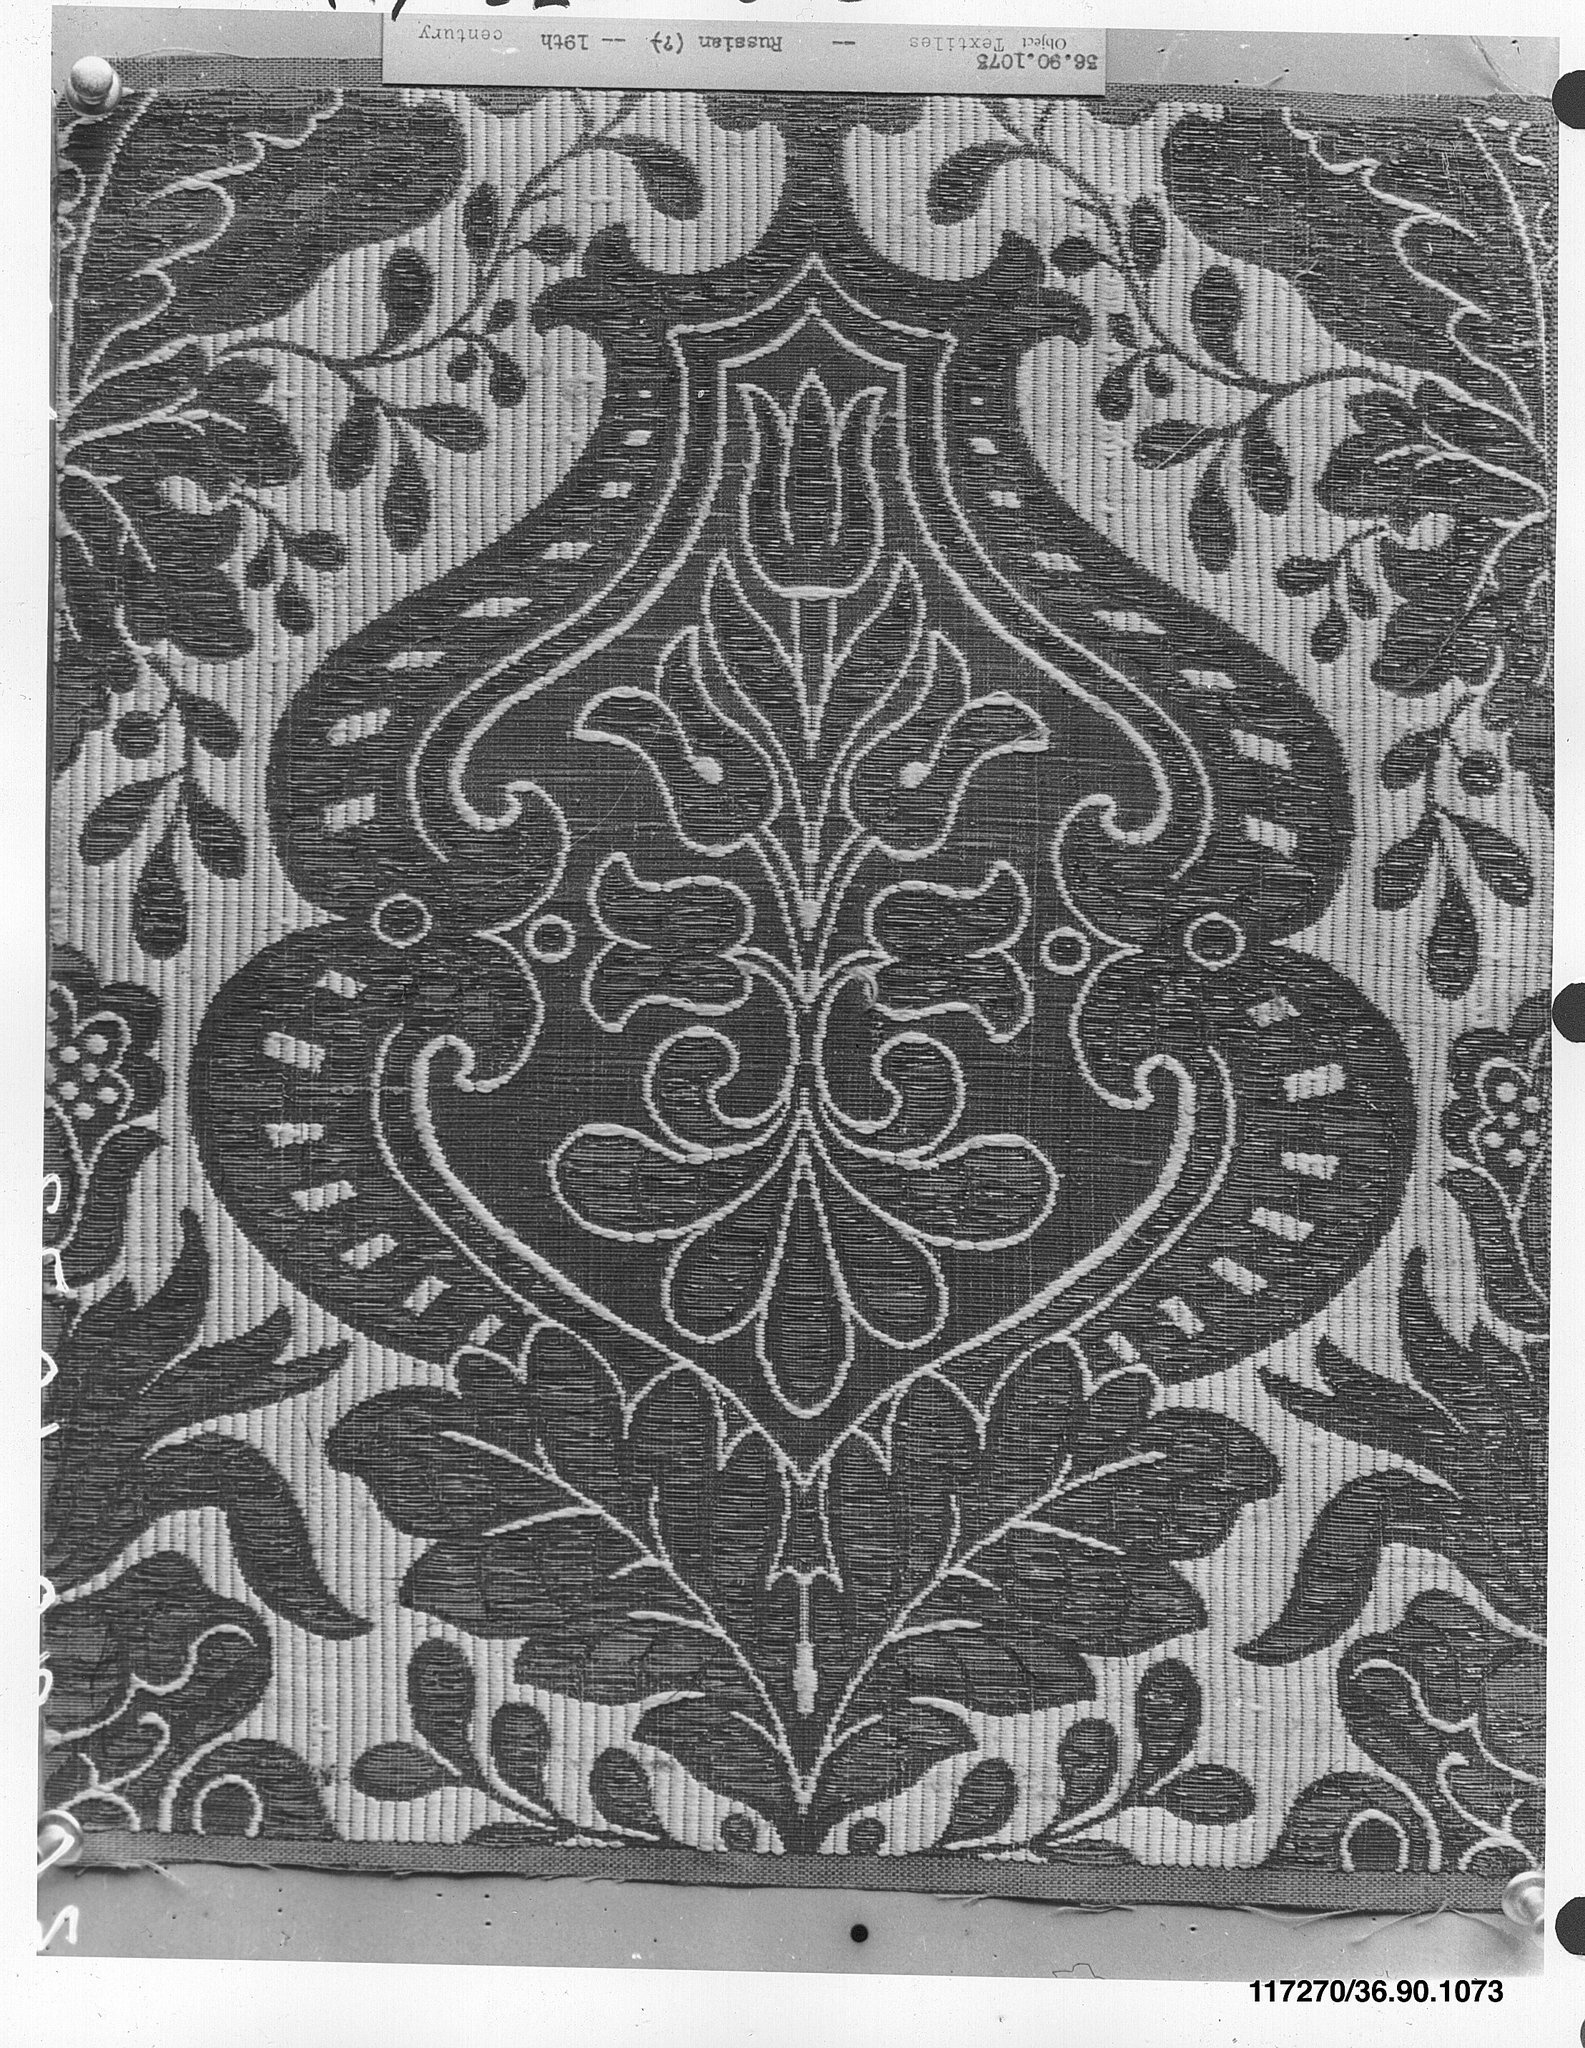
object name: piece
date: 1801-1900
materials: metal thread, silk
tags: flowers,leaves